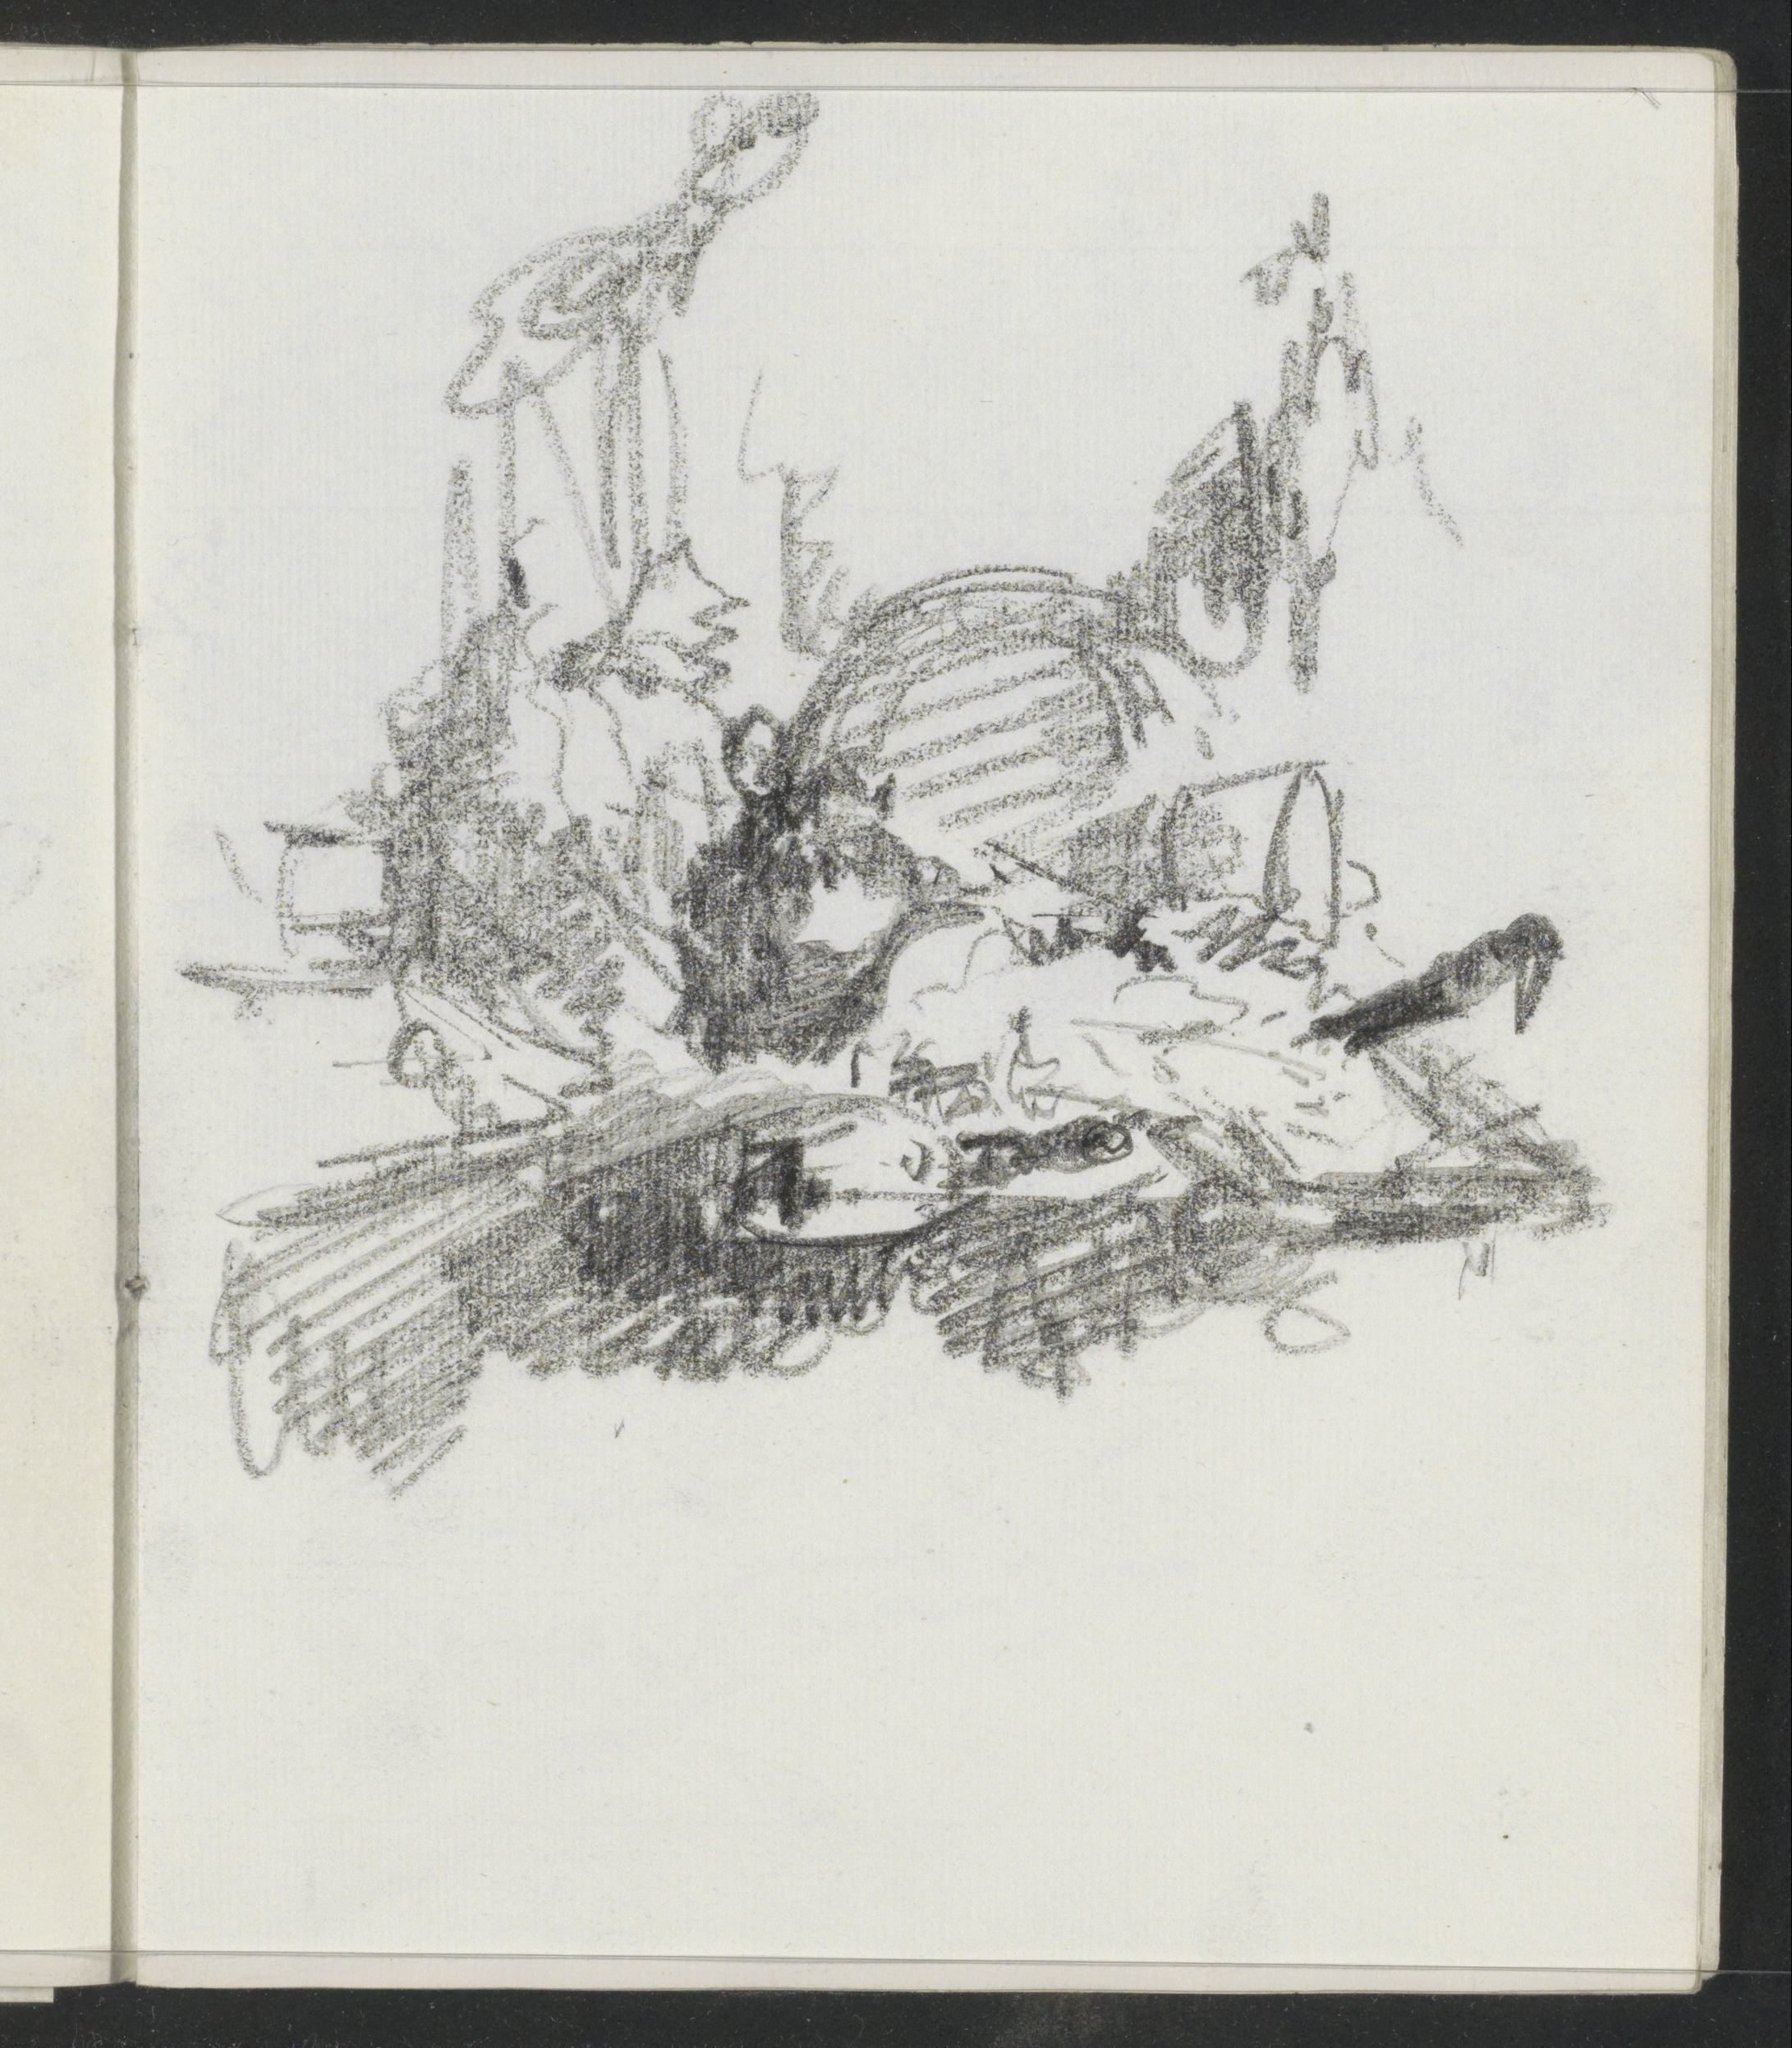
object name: sketchbook leaf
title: Studie, mogelijk een stilleven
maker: maria vos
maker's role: draughtsman, painter, print maker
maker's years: 1824-1906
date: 1834-1906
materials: paper, pencil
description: Blad 8 recto uit een schetsboek met 20 bladen.